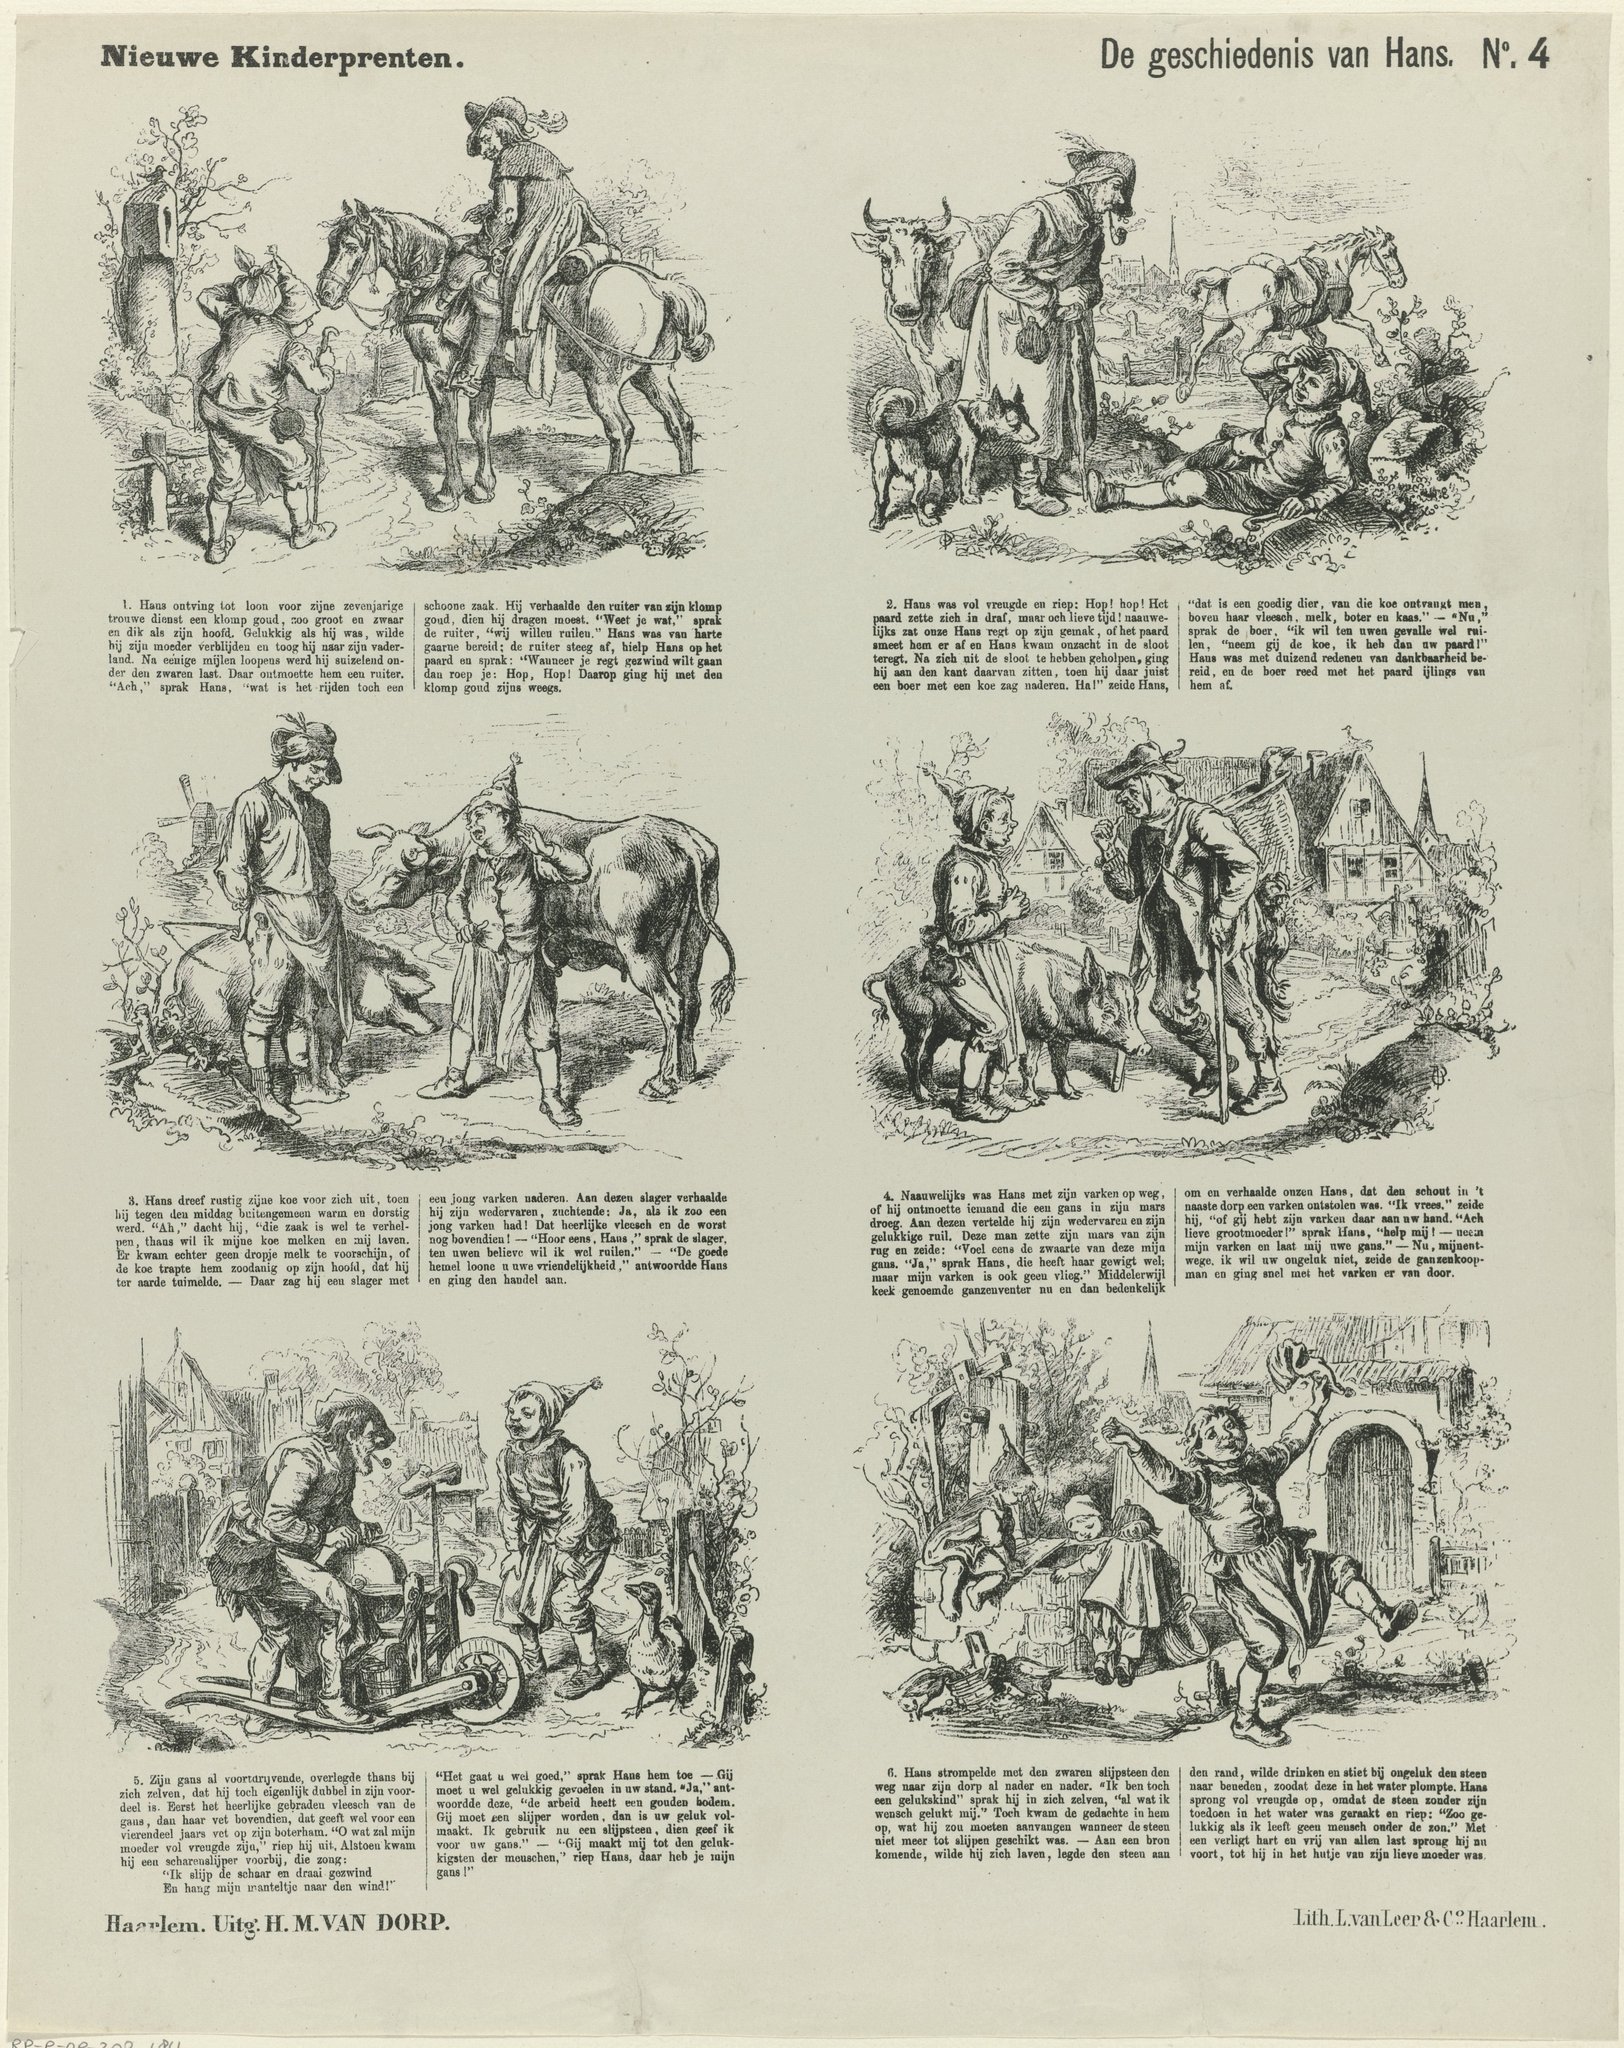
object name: popular print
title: Nieuwe kinderprenten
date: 1872-1883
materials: paper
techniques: letterpress printing, lithograph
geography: haarlem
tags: animals, parts of machines: mill-stone, tales and fairy tales, horse, trade, commerce and finance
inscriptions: collector's mark: Lugt 2760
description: Blad met 6 voorstellingen over het jongetje Hans dat goud verdiende, dit ruilde voor een paard en zo doorging tot hij eindigde met een molensteen en die in een waterput gooide. Onder elke voorstelling een onderschrift in twee kolommen. Genummerd rechtsboven: No. 4.